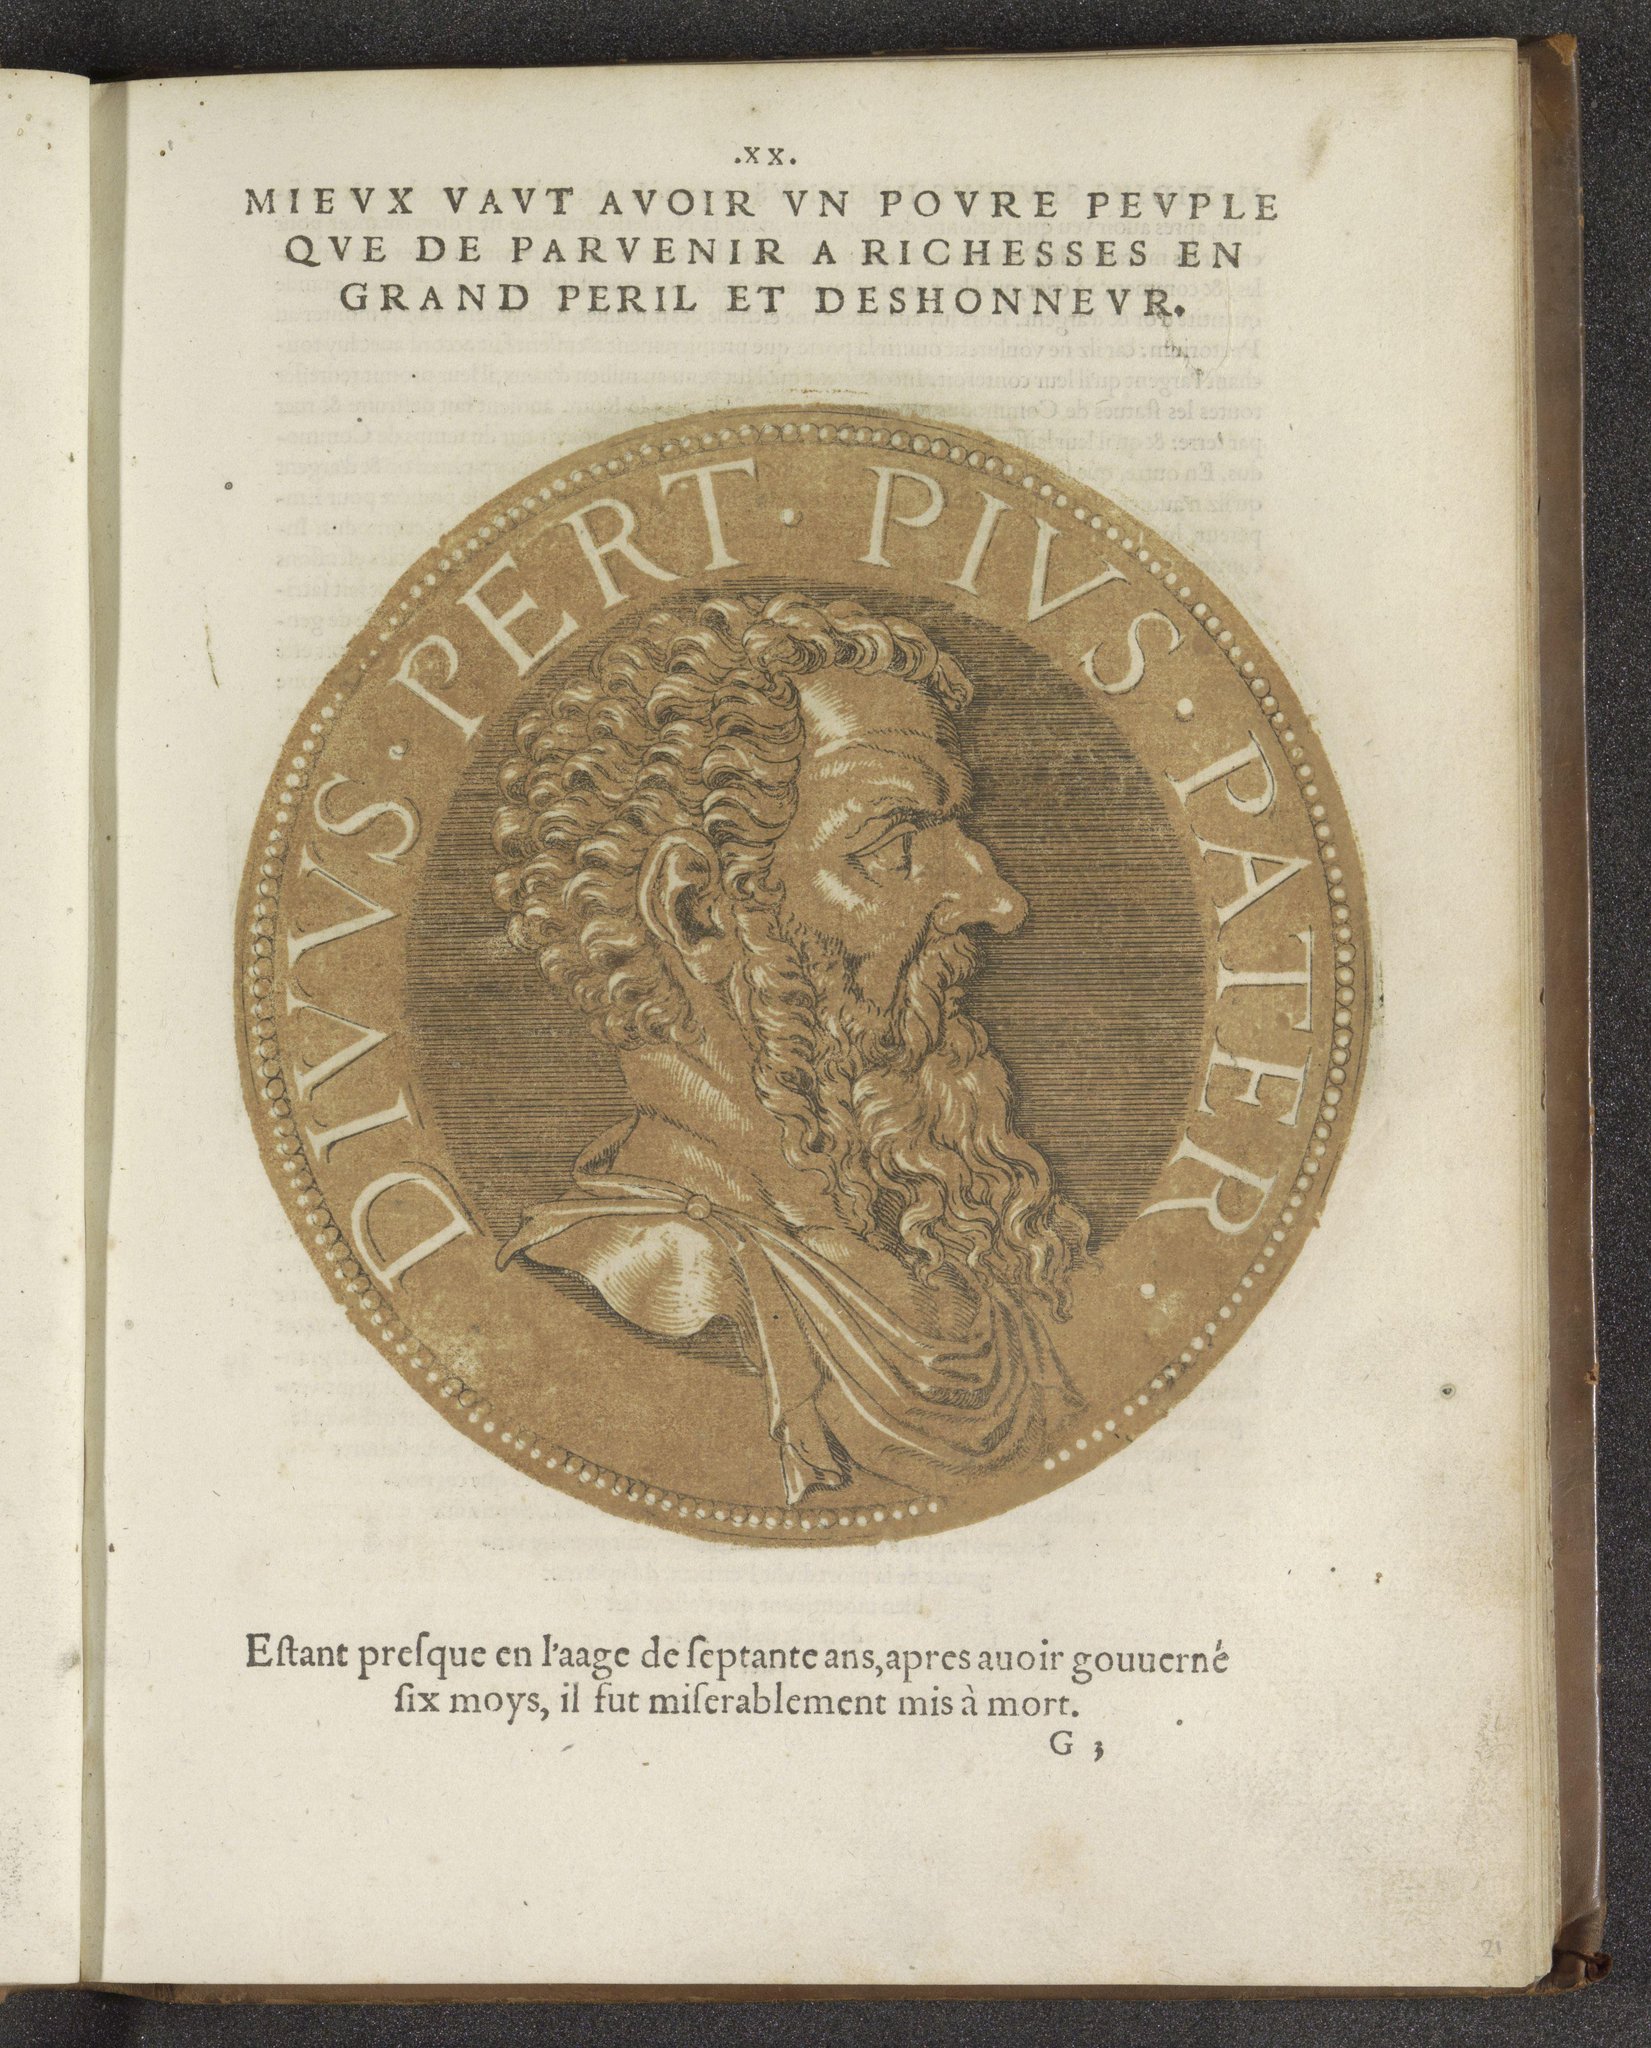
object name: print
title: Les images presque de tous les empereurs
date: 1557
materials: paper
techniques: woodcut, etching, letterpress printing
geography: antwerp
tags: emperor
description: Portret van keizer Pertinax, op een munt met randschrift. De prent maakt deel uit van een boek over de keizers vanaf Julius Caesar tot en met Karel V en zijn broer Ferdinand.